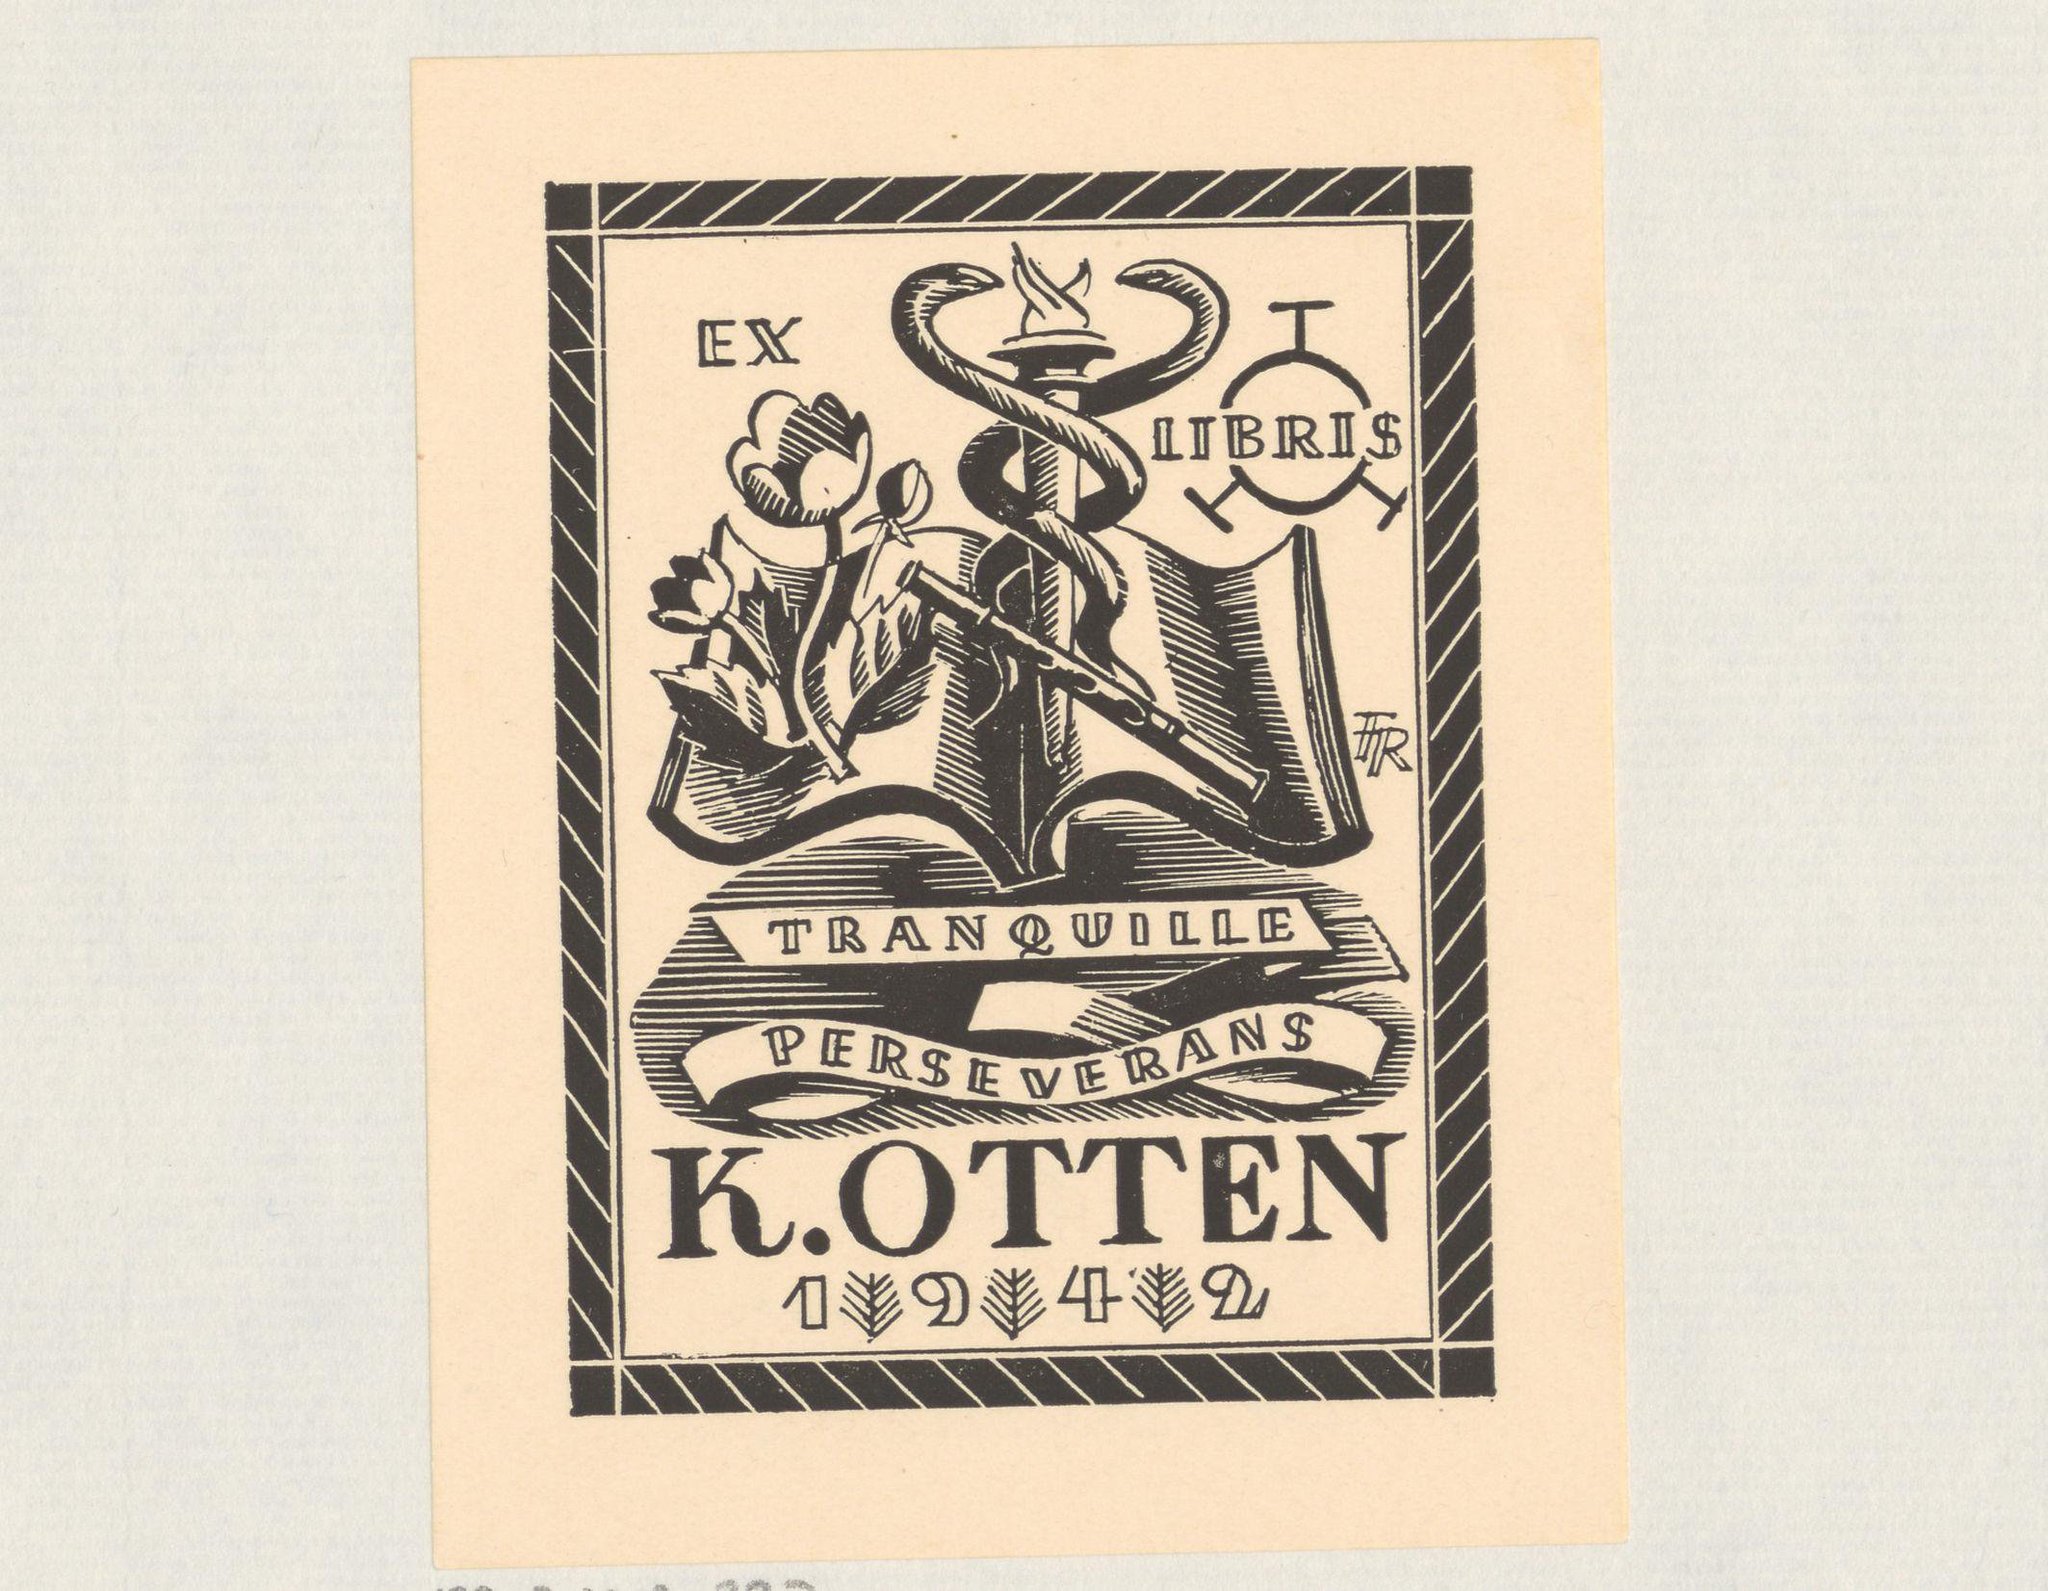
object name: bookplate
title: Ex libris van K. Otten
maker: frederik hermann paul reitmann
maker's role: painter, print maker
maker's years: 1903-1963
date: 1942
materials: paper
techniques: printing block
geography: netherlands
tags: flowers, book, caduceus (staff with two snakes, attribute of mercury), flute, aulos, tibia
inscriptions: inscription: ‘370 / Fr. Reitman / Med. ex libris’